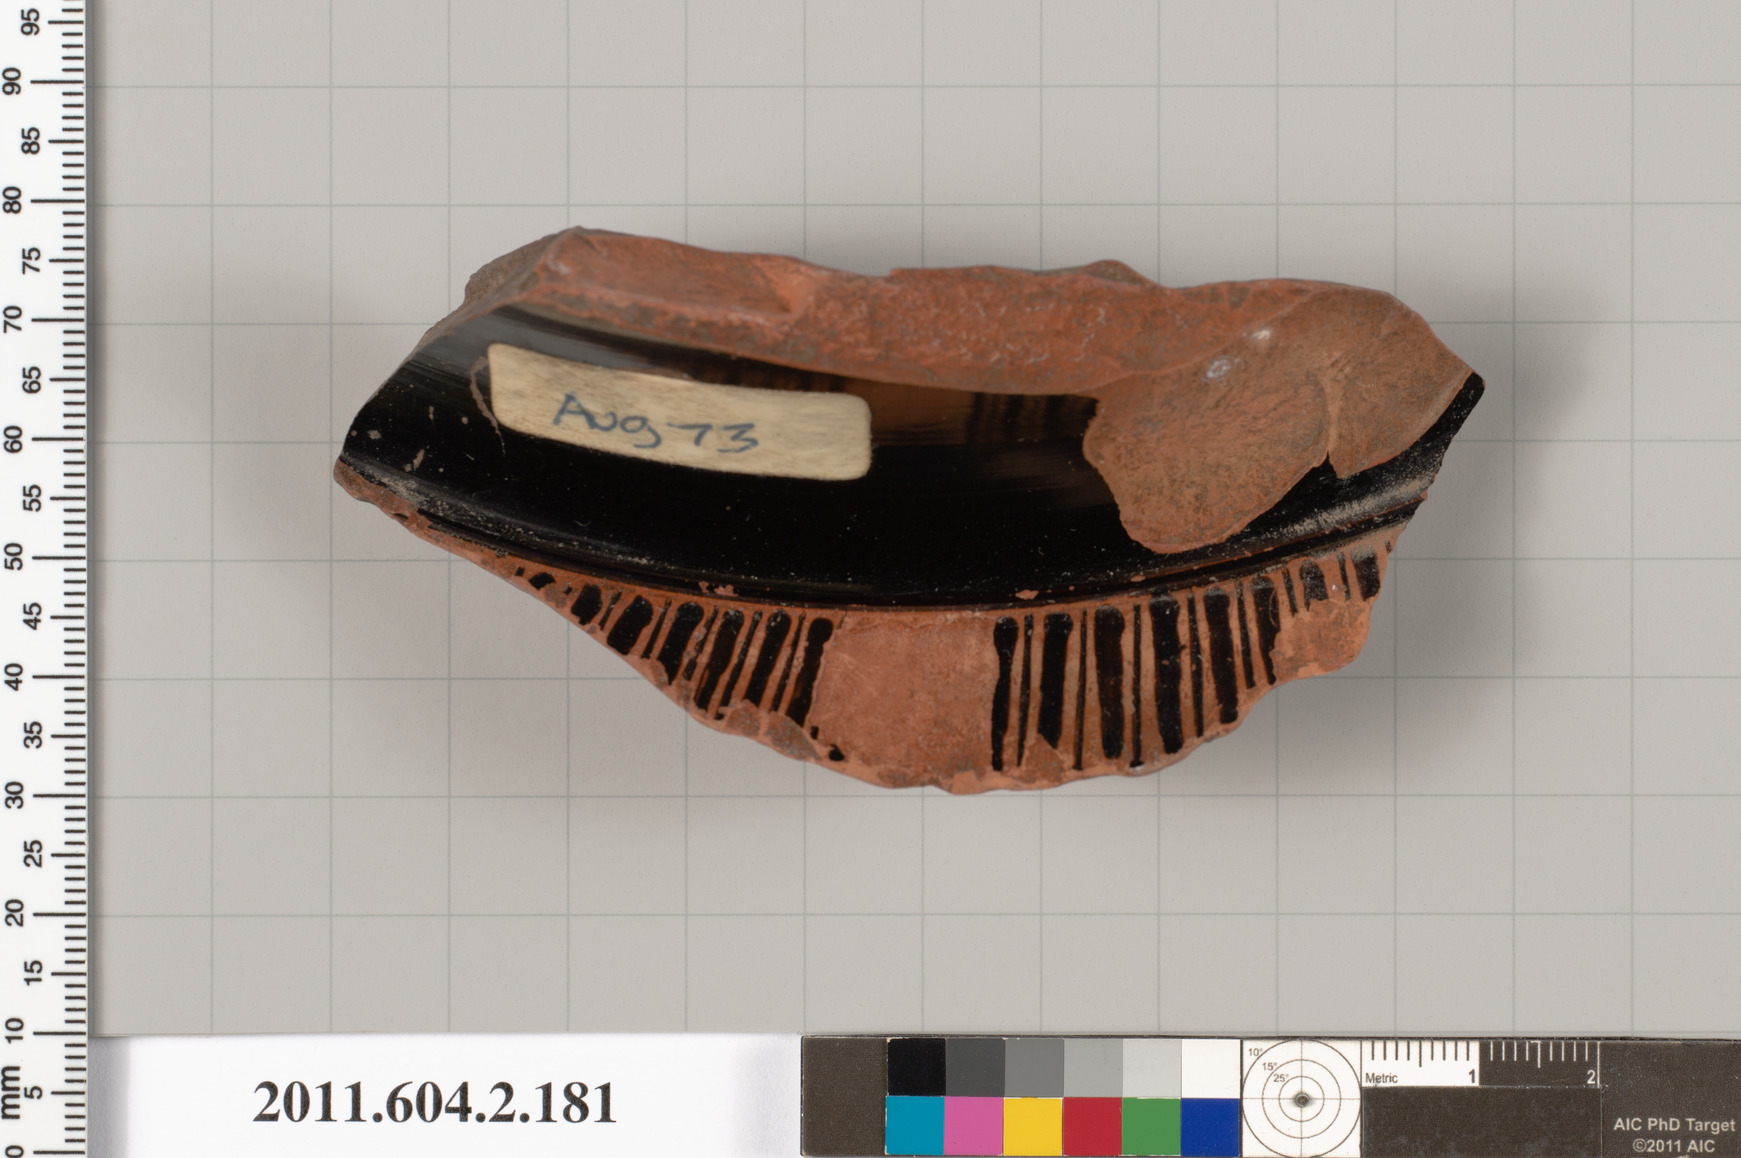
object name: stamnos fragment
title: Terracotta fragment of a stamnos (jar)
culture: greek, attic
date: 520-500 BCE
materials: terracotta